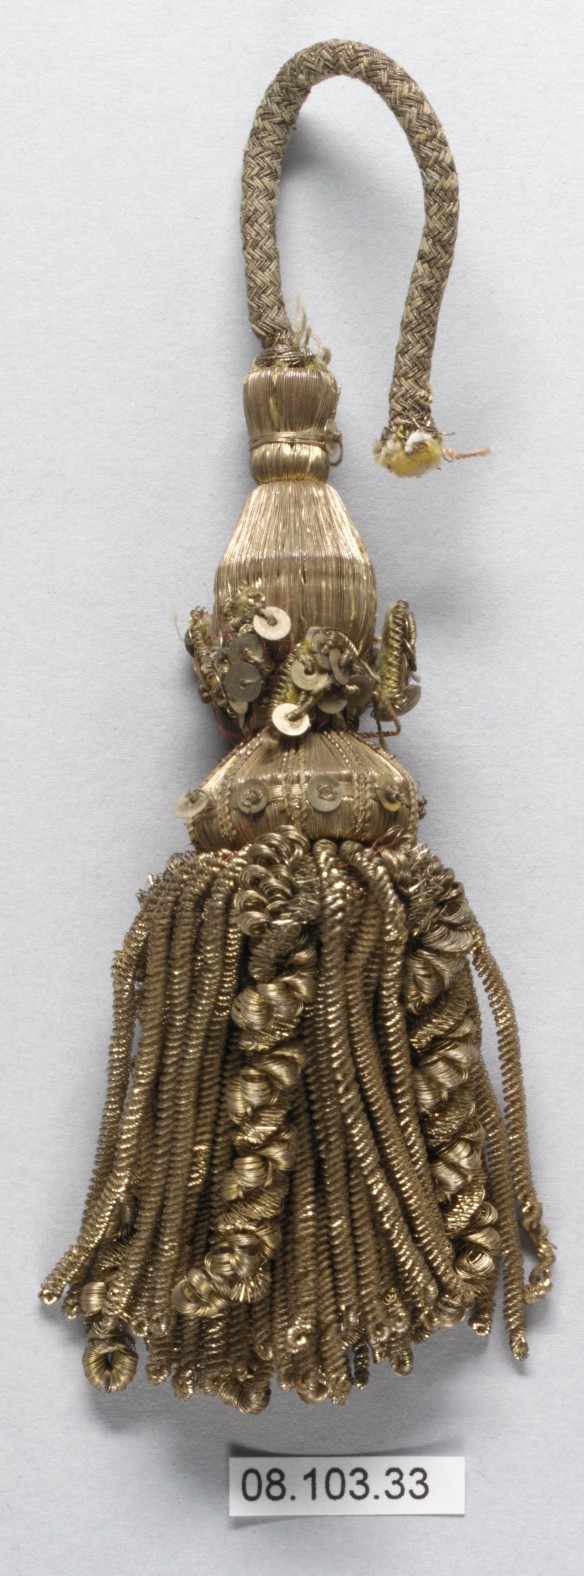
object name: tassel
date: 1801-1833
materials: metal thread